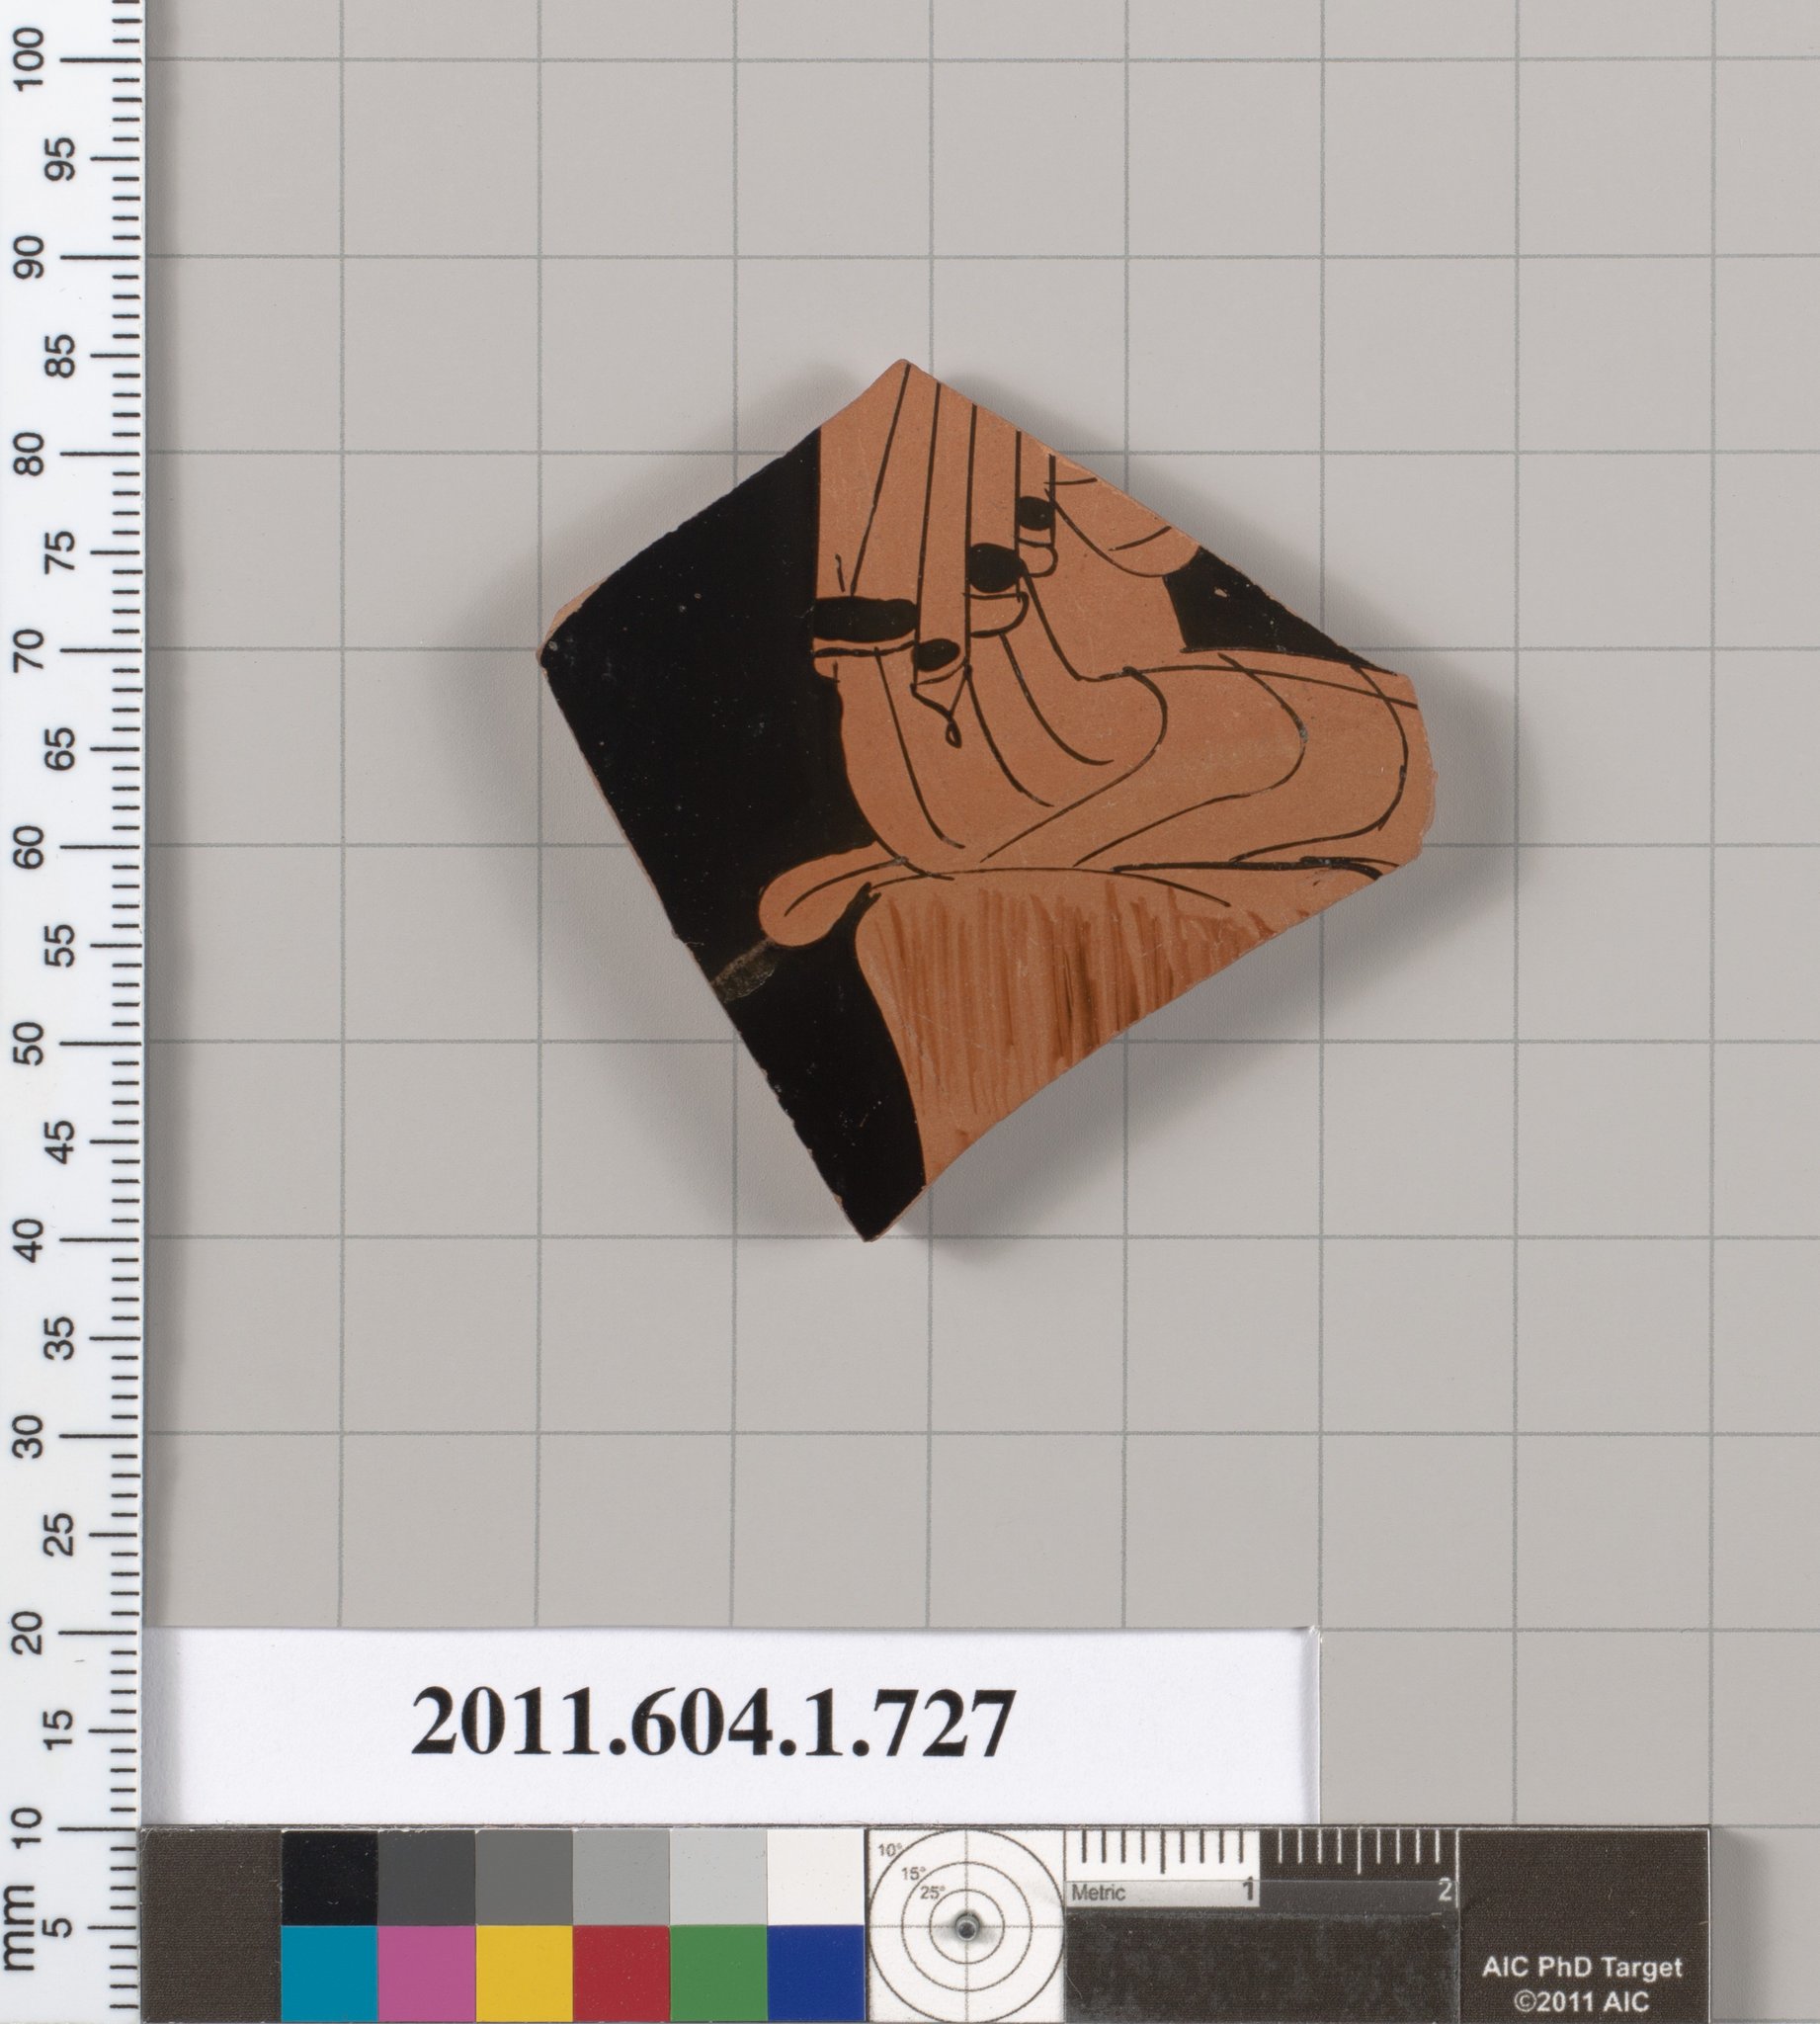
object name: kylix fragment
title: Terracotta fragment of a kylix (drinking cup)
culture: greek, attic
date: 475-451 BCE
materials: terracotta